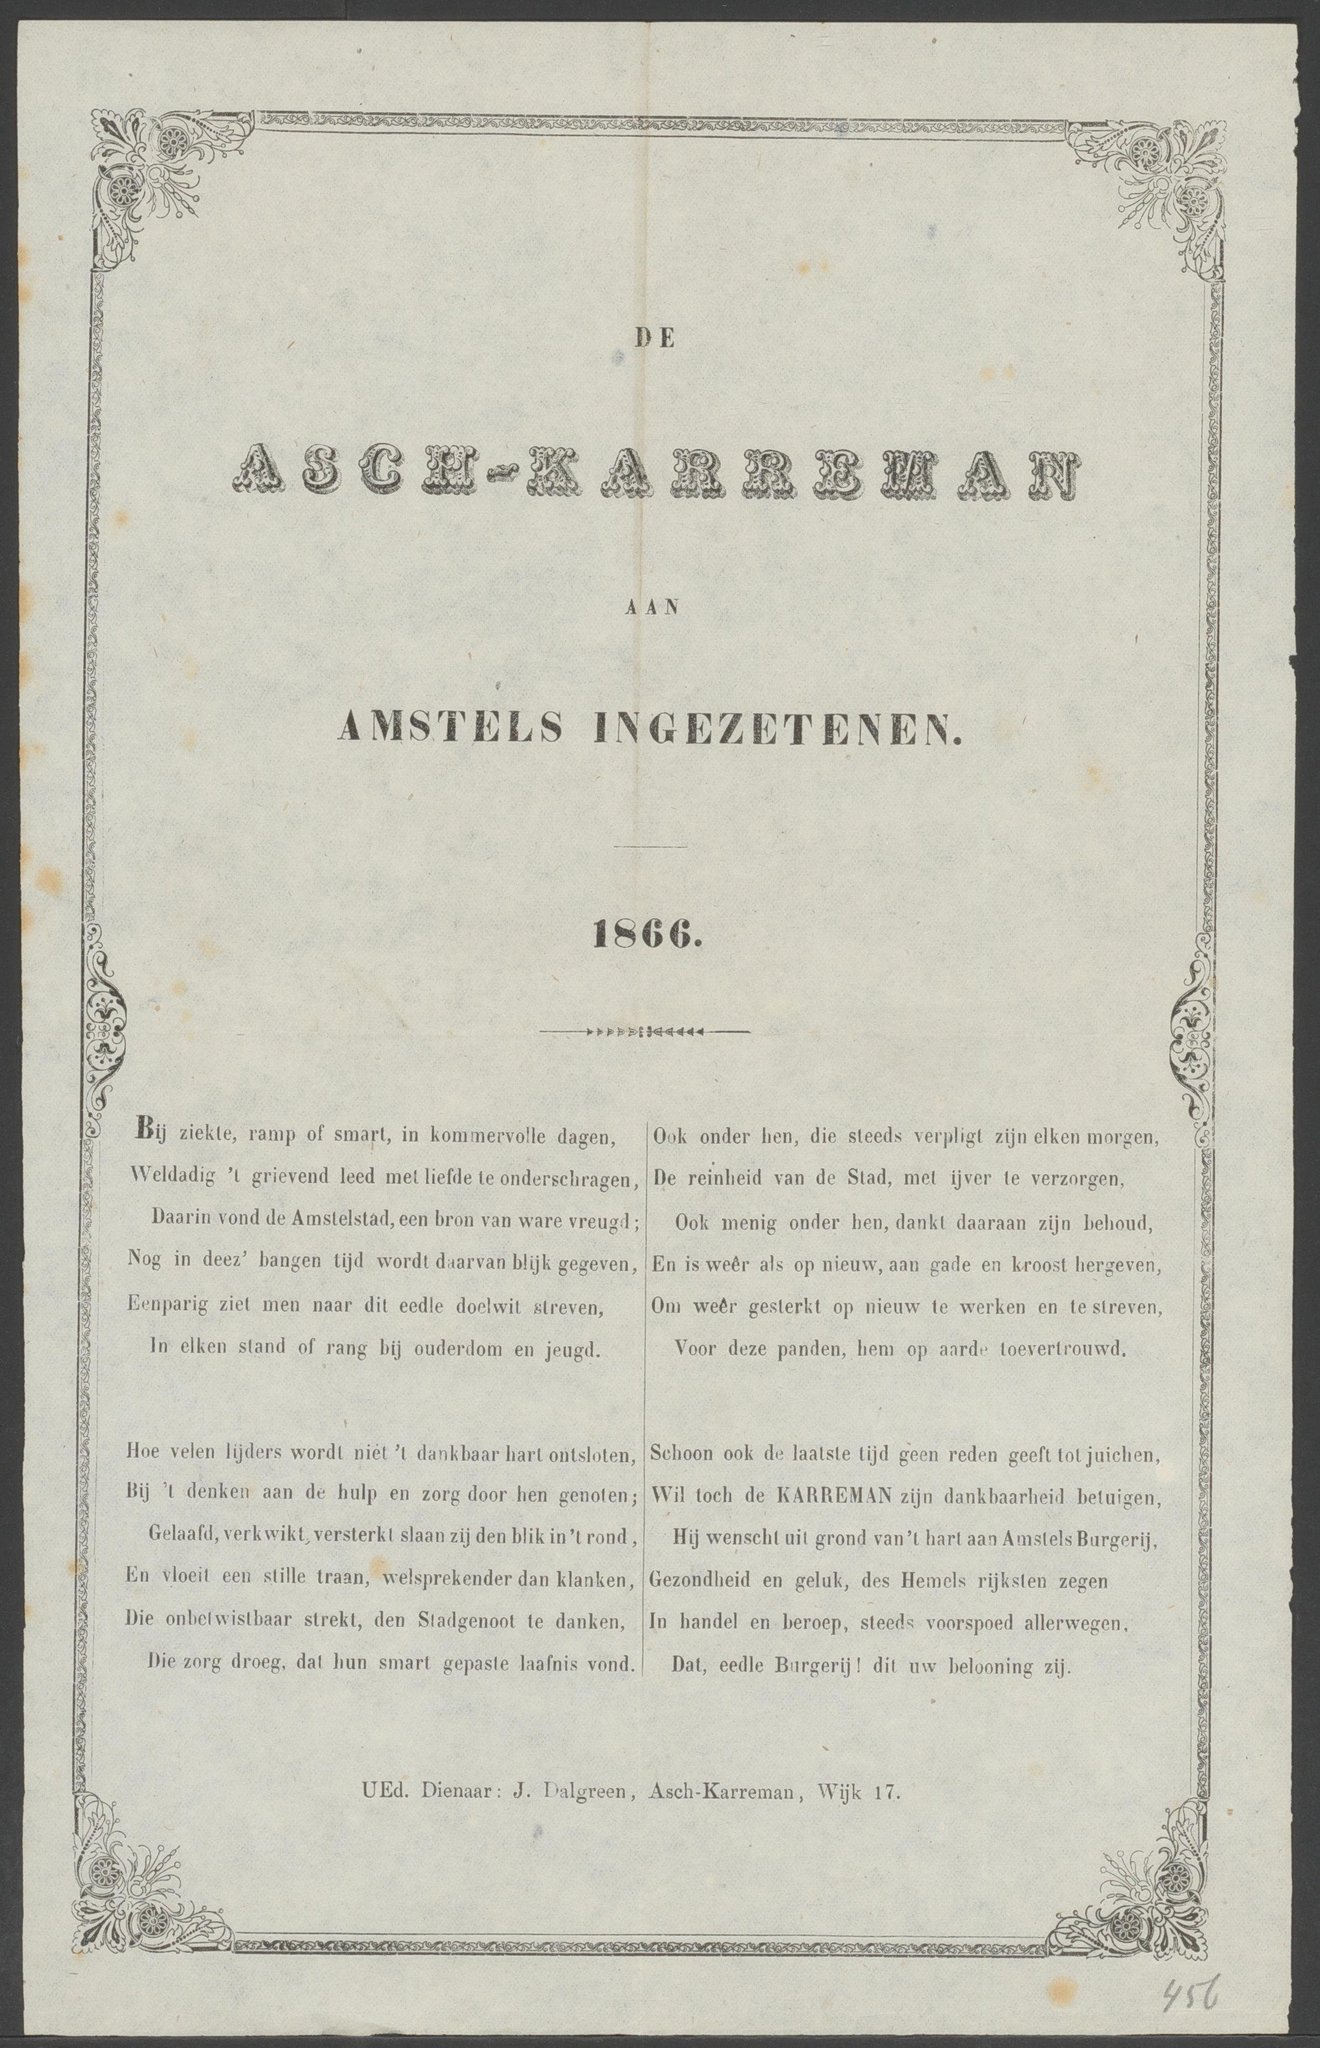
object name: text sheet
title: De Asch-karreman aan Amstels ingezetenen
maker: Anonymous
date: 1866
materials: paper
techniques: letterpress printing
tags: garbage collection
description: Kermisprent namens de askarrenmannen (karrenman of vuilnisman) te Amsterdam, september 1866. Namens J. Dalgreen, de askarreman van wijk no. 17. Onderwerpsrubrieken binnen de Atlas Zeden en Gewoonten: Zeden en gewoonten in engeren zin, Volksleven, Volksbladen, Nieuwjaars- en Kerstwenschen, Amsterdam.